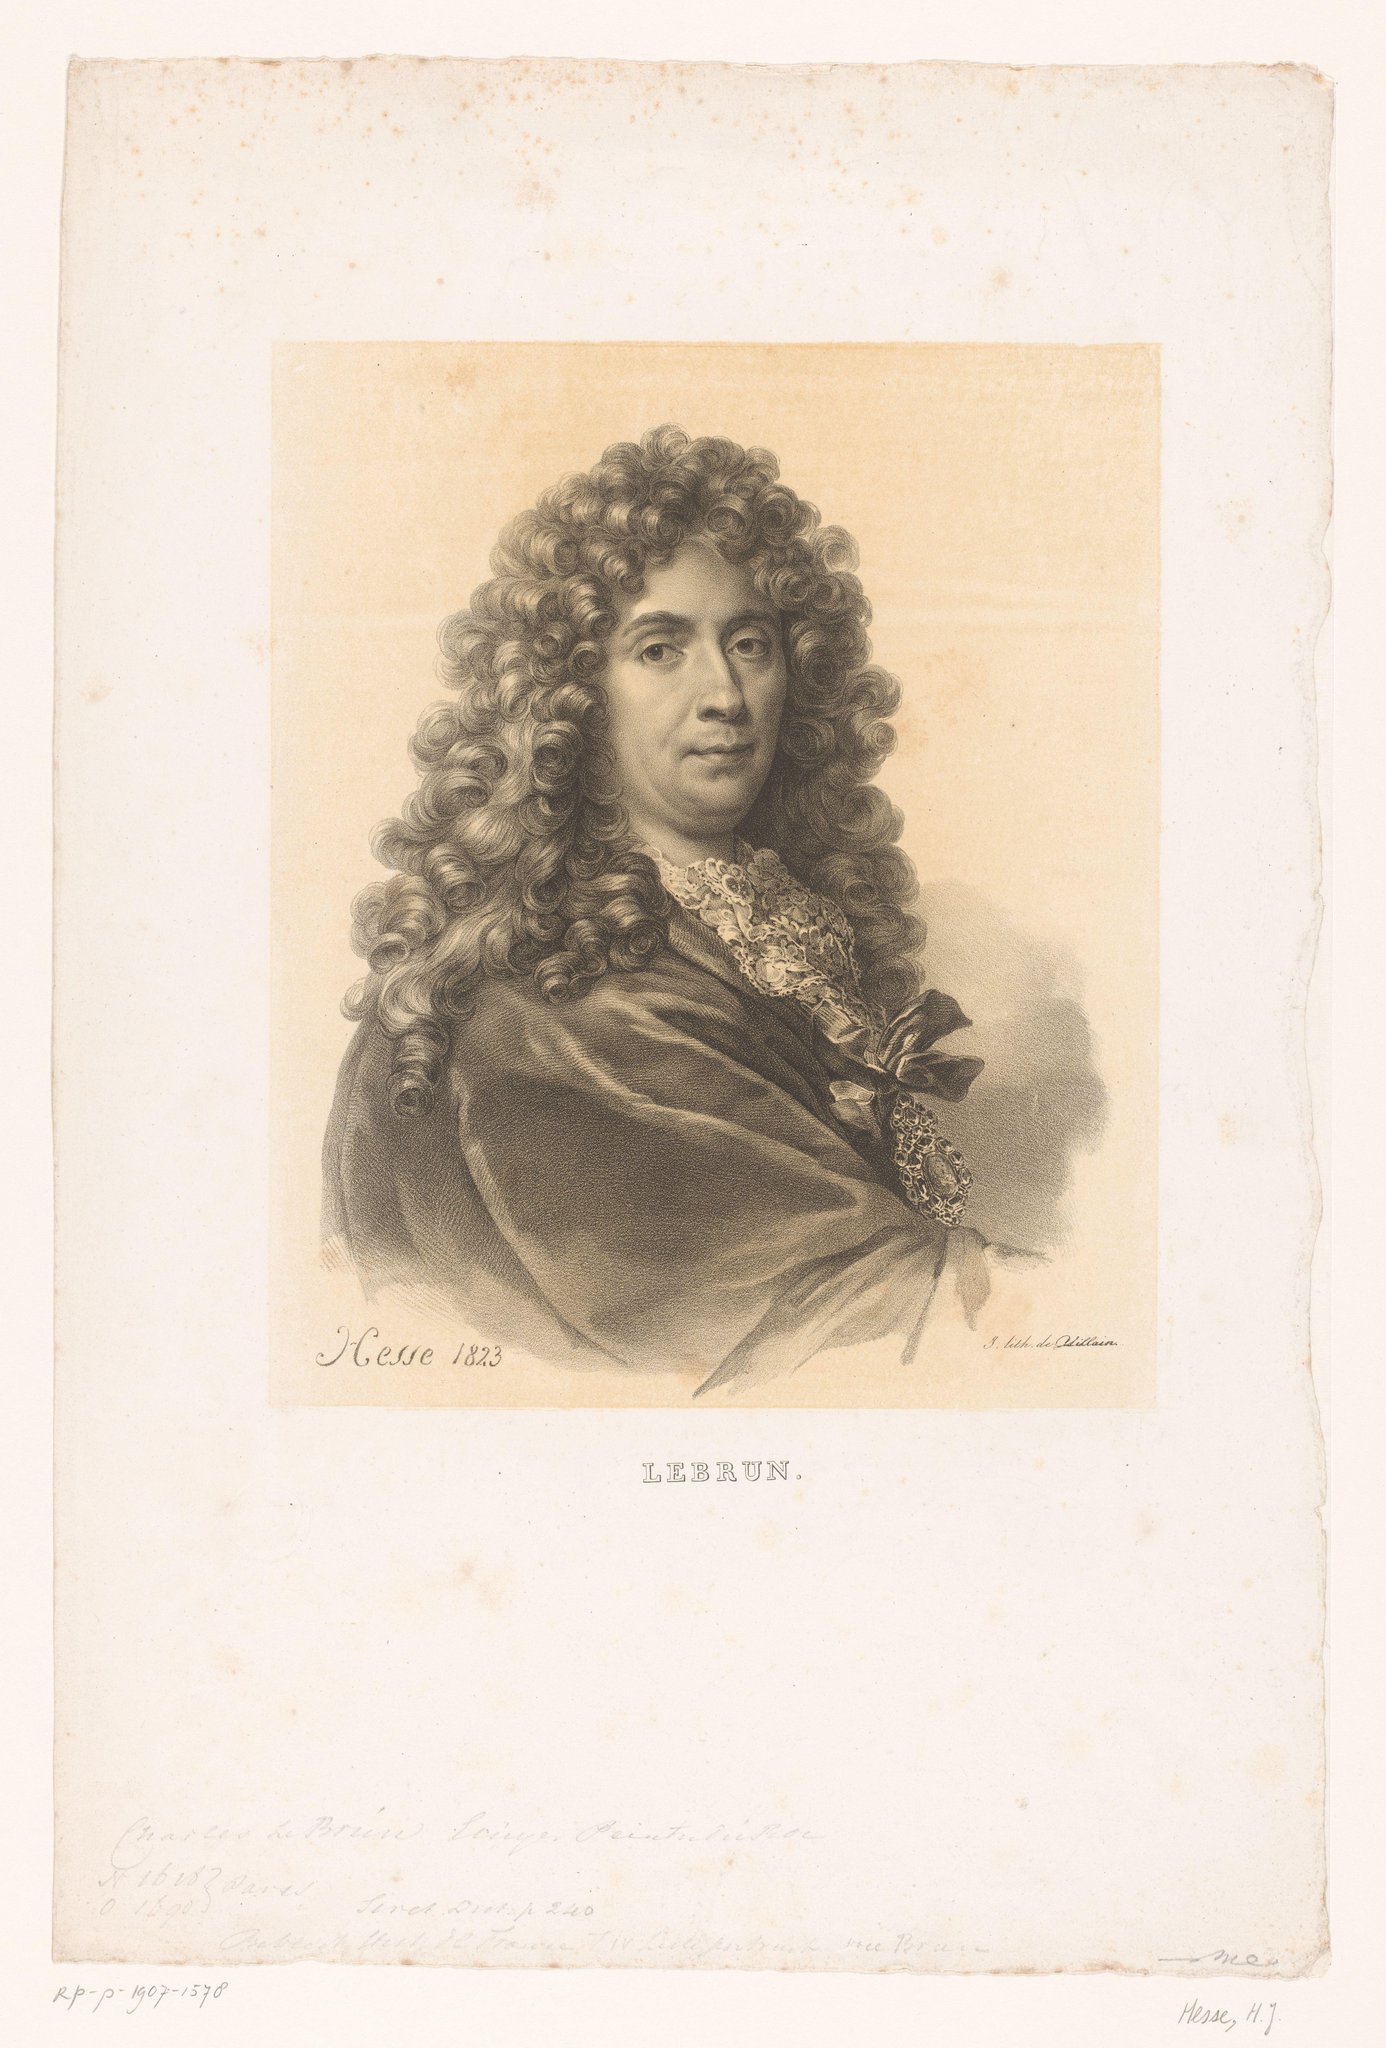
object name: print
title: Le Brun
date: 1823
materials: paper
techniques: lithograph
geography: paris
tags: paris, draughtsman, charles le brun, historical persons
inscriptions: check stamp: ‘JC (?)’, collector's mark: Lugt 2228a